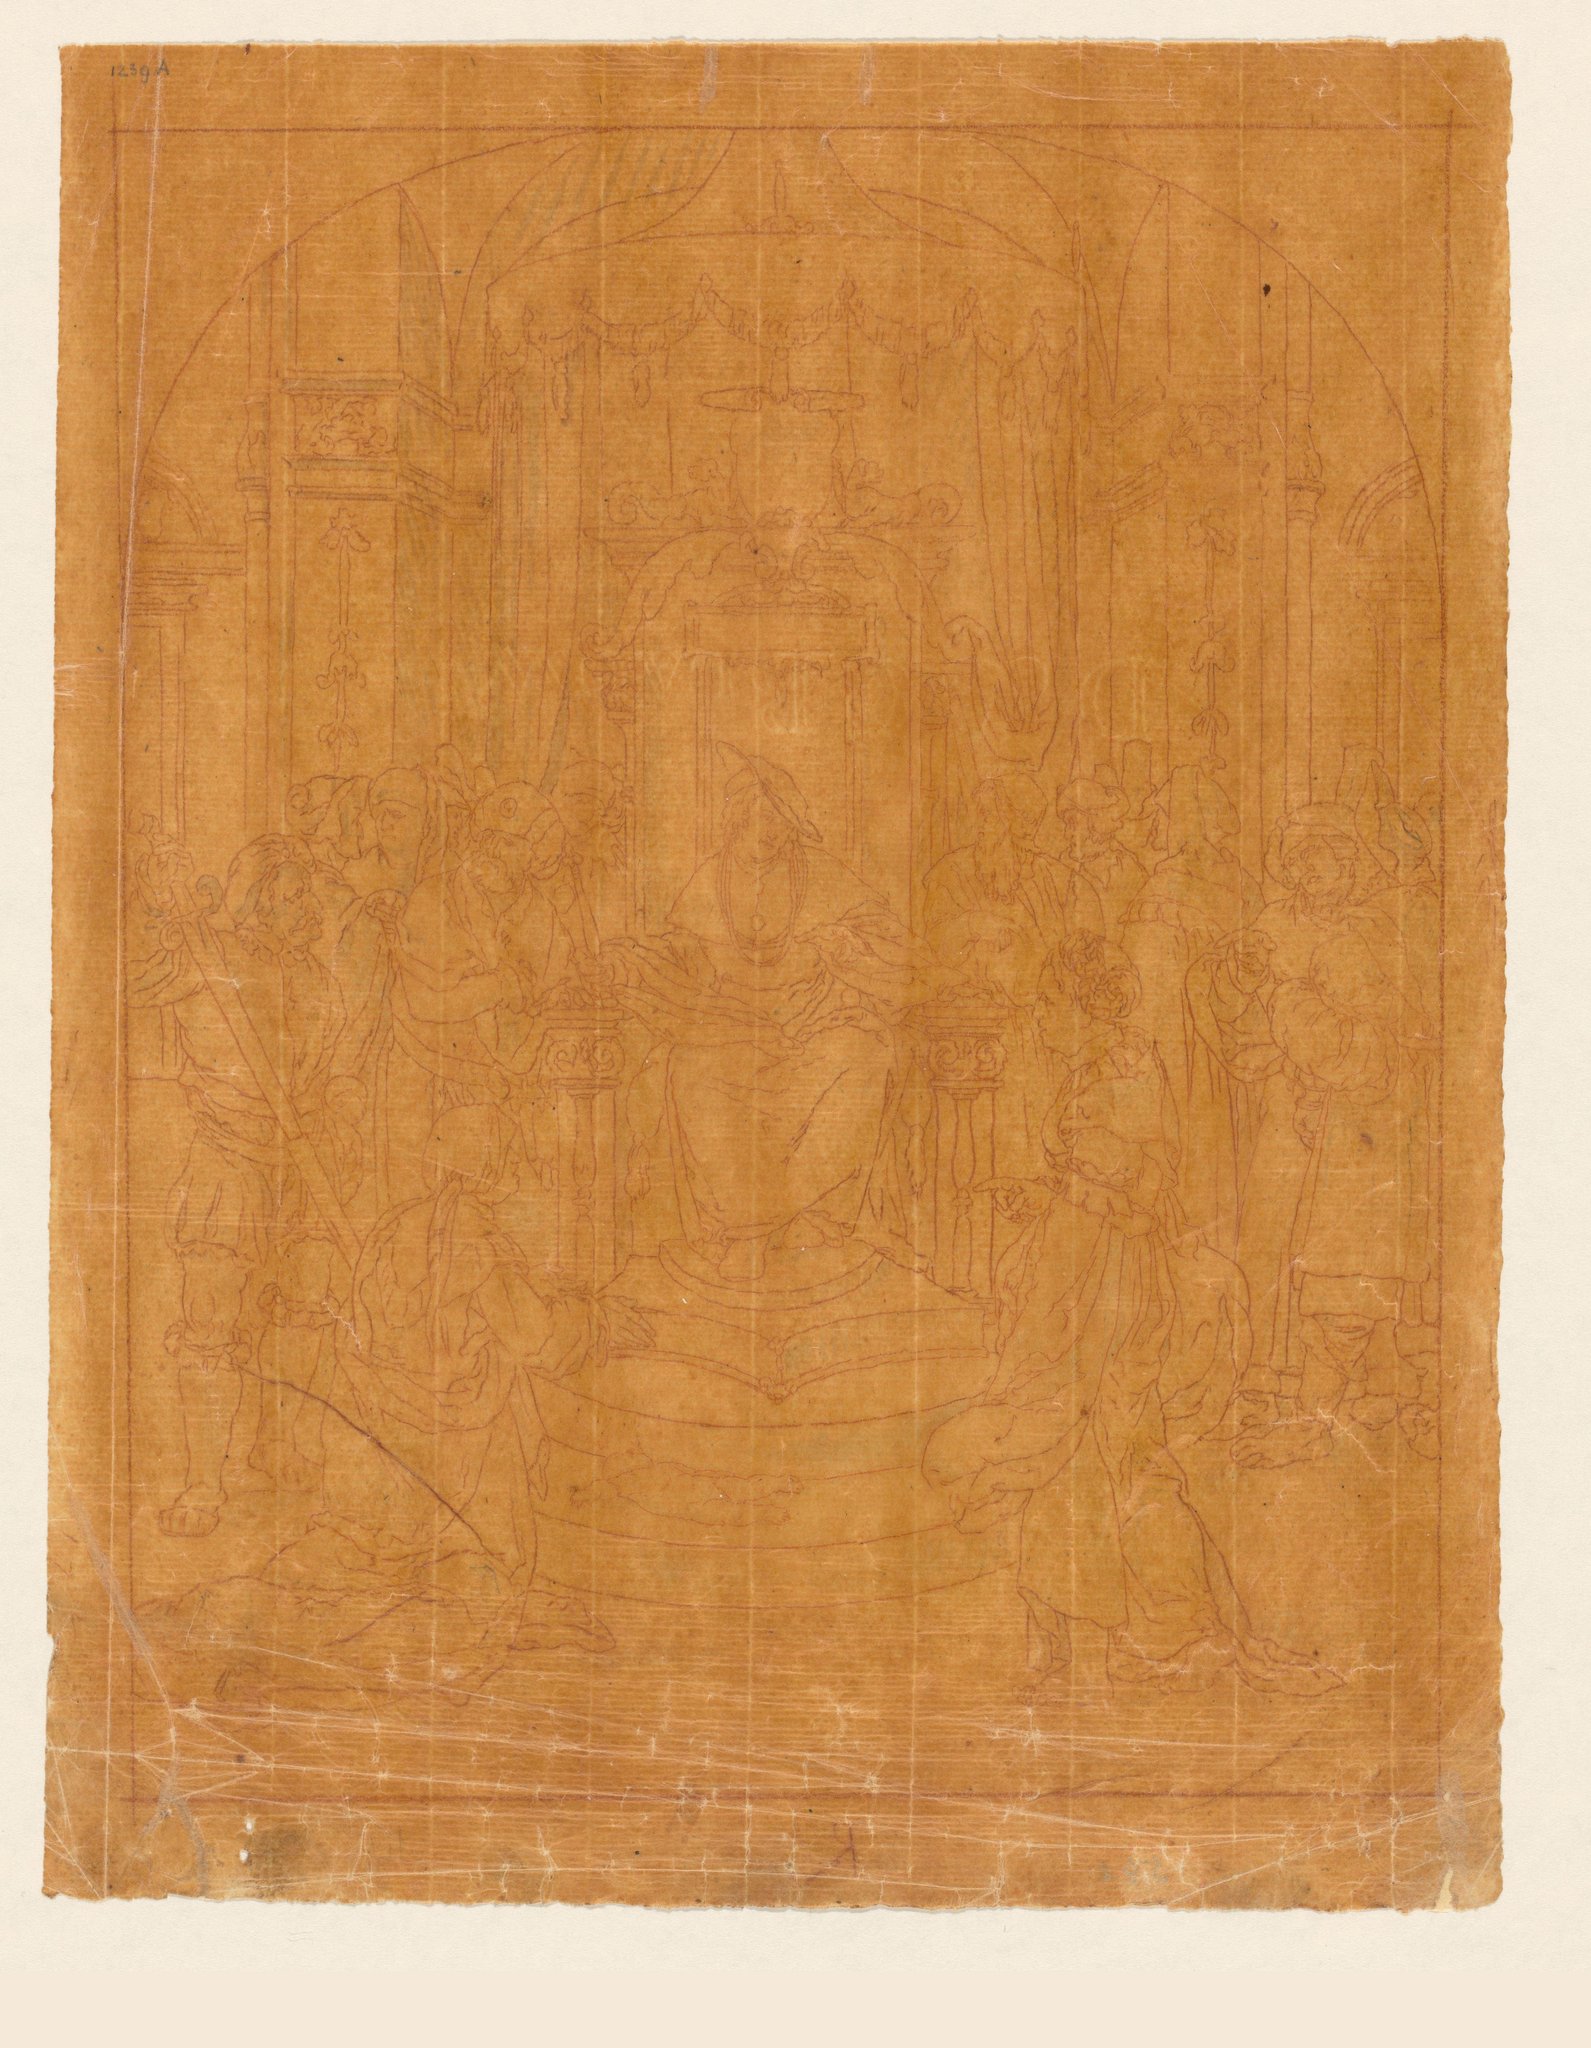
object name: tracing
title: Oordeel van Salomo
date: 1782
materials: chalk, paper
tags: the judgement of solomon (1 kings 3:16-28)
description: Koning Salomo zit op zijn troon en velt zijn oordeel. Hij geeft de opdracht om de baby in tweeën te laten delen om te bepalen wie de moeder van het kind is. Rechts trekt een man zijn zwaard. Voor de troon de twee vrouwen die beiden het moederschap van het kind claimen. De calque ligt los in een album, zie blad 34.